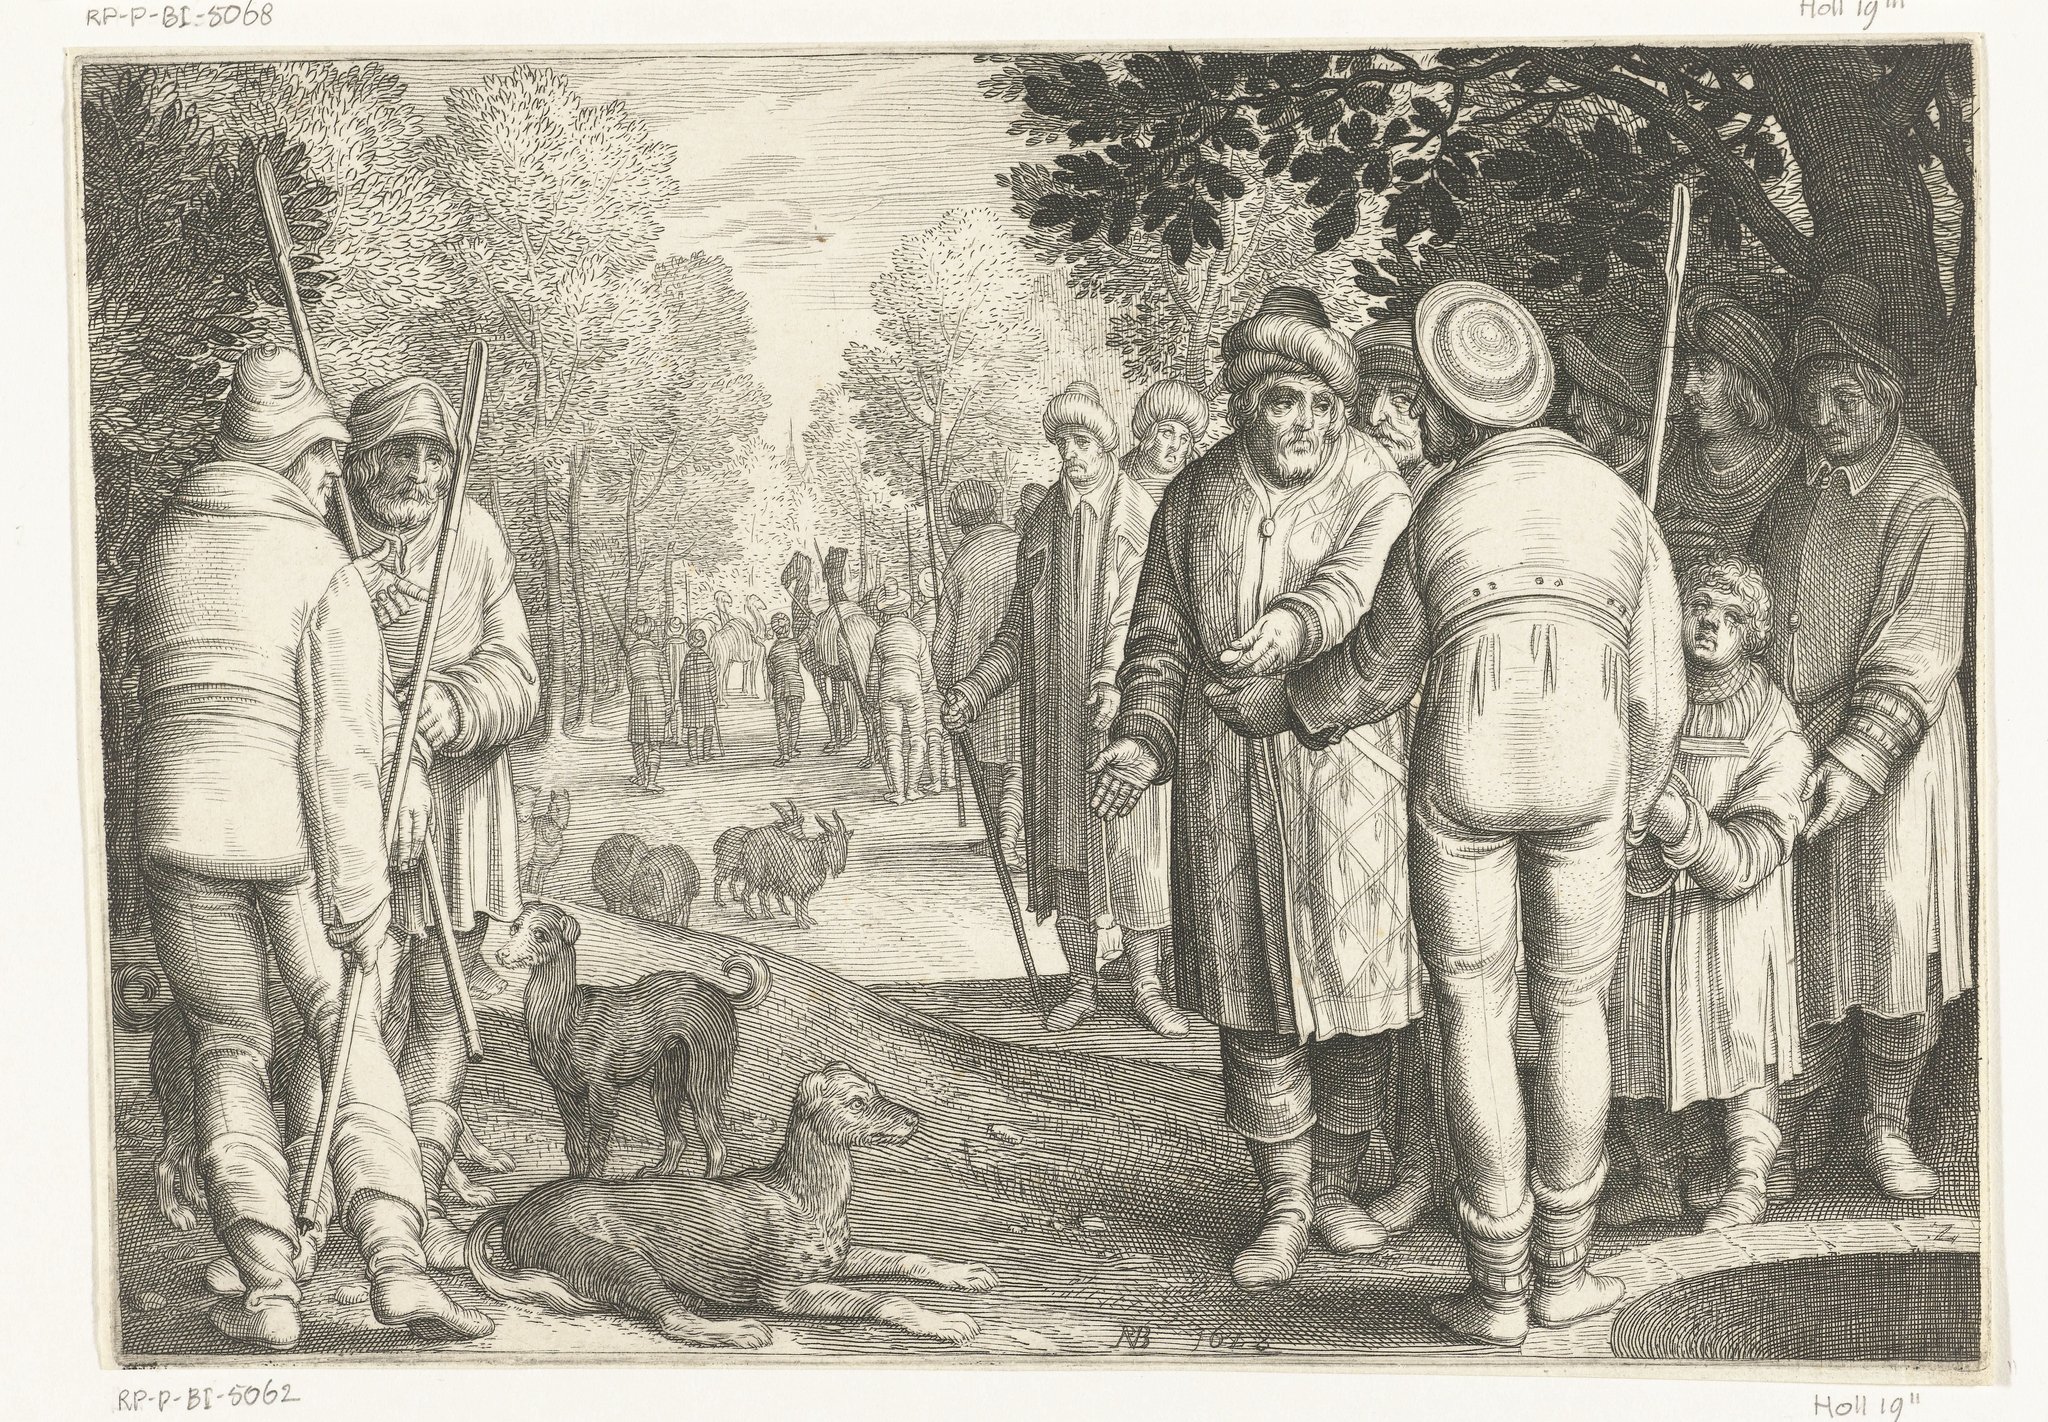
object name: print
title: Jozef wordt door zijn broers verkocht aan kooplieden bij de put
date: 1628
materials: paper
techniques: engraving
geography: netherlands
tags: joseph is sold for twenty pieces of silver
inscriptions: collector's mark: Lugt 2228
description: Prent uit serie van zes prenten met het verhaal van Jozef. De serie is geïnspireerd op een vergelijkbare reeks van Lucas van Leyden.